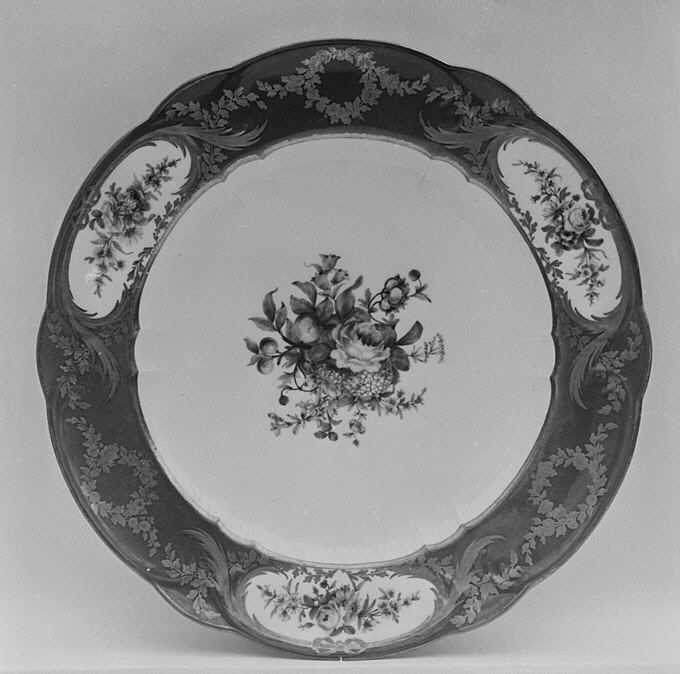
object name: plate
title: Plate (part of a service)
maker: sèvres manufactory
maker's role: manufactory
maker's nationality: french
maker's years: 1740-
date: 1784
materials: soft paste porcelain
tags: flowers